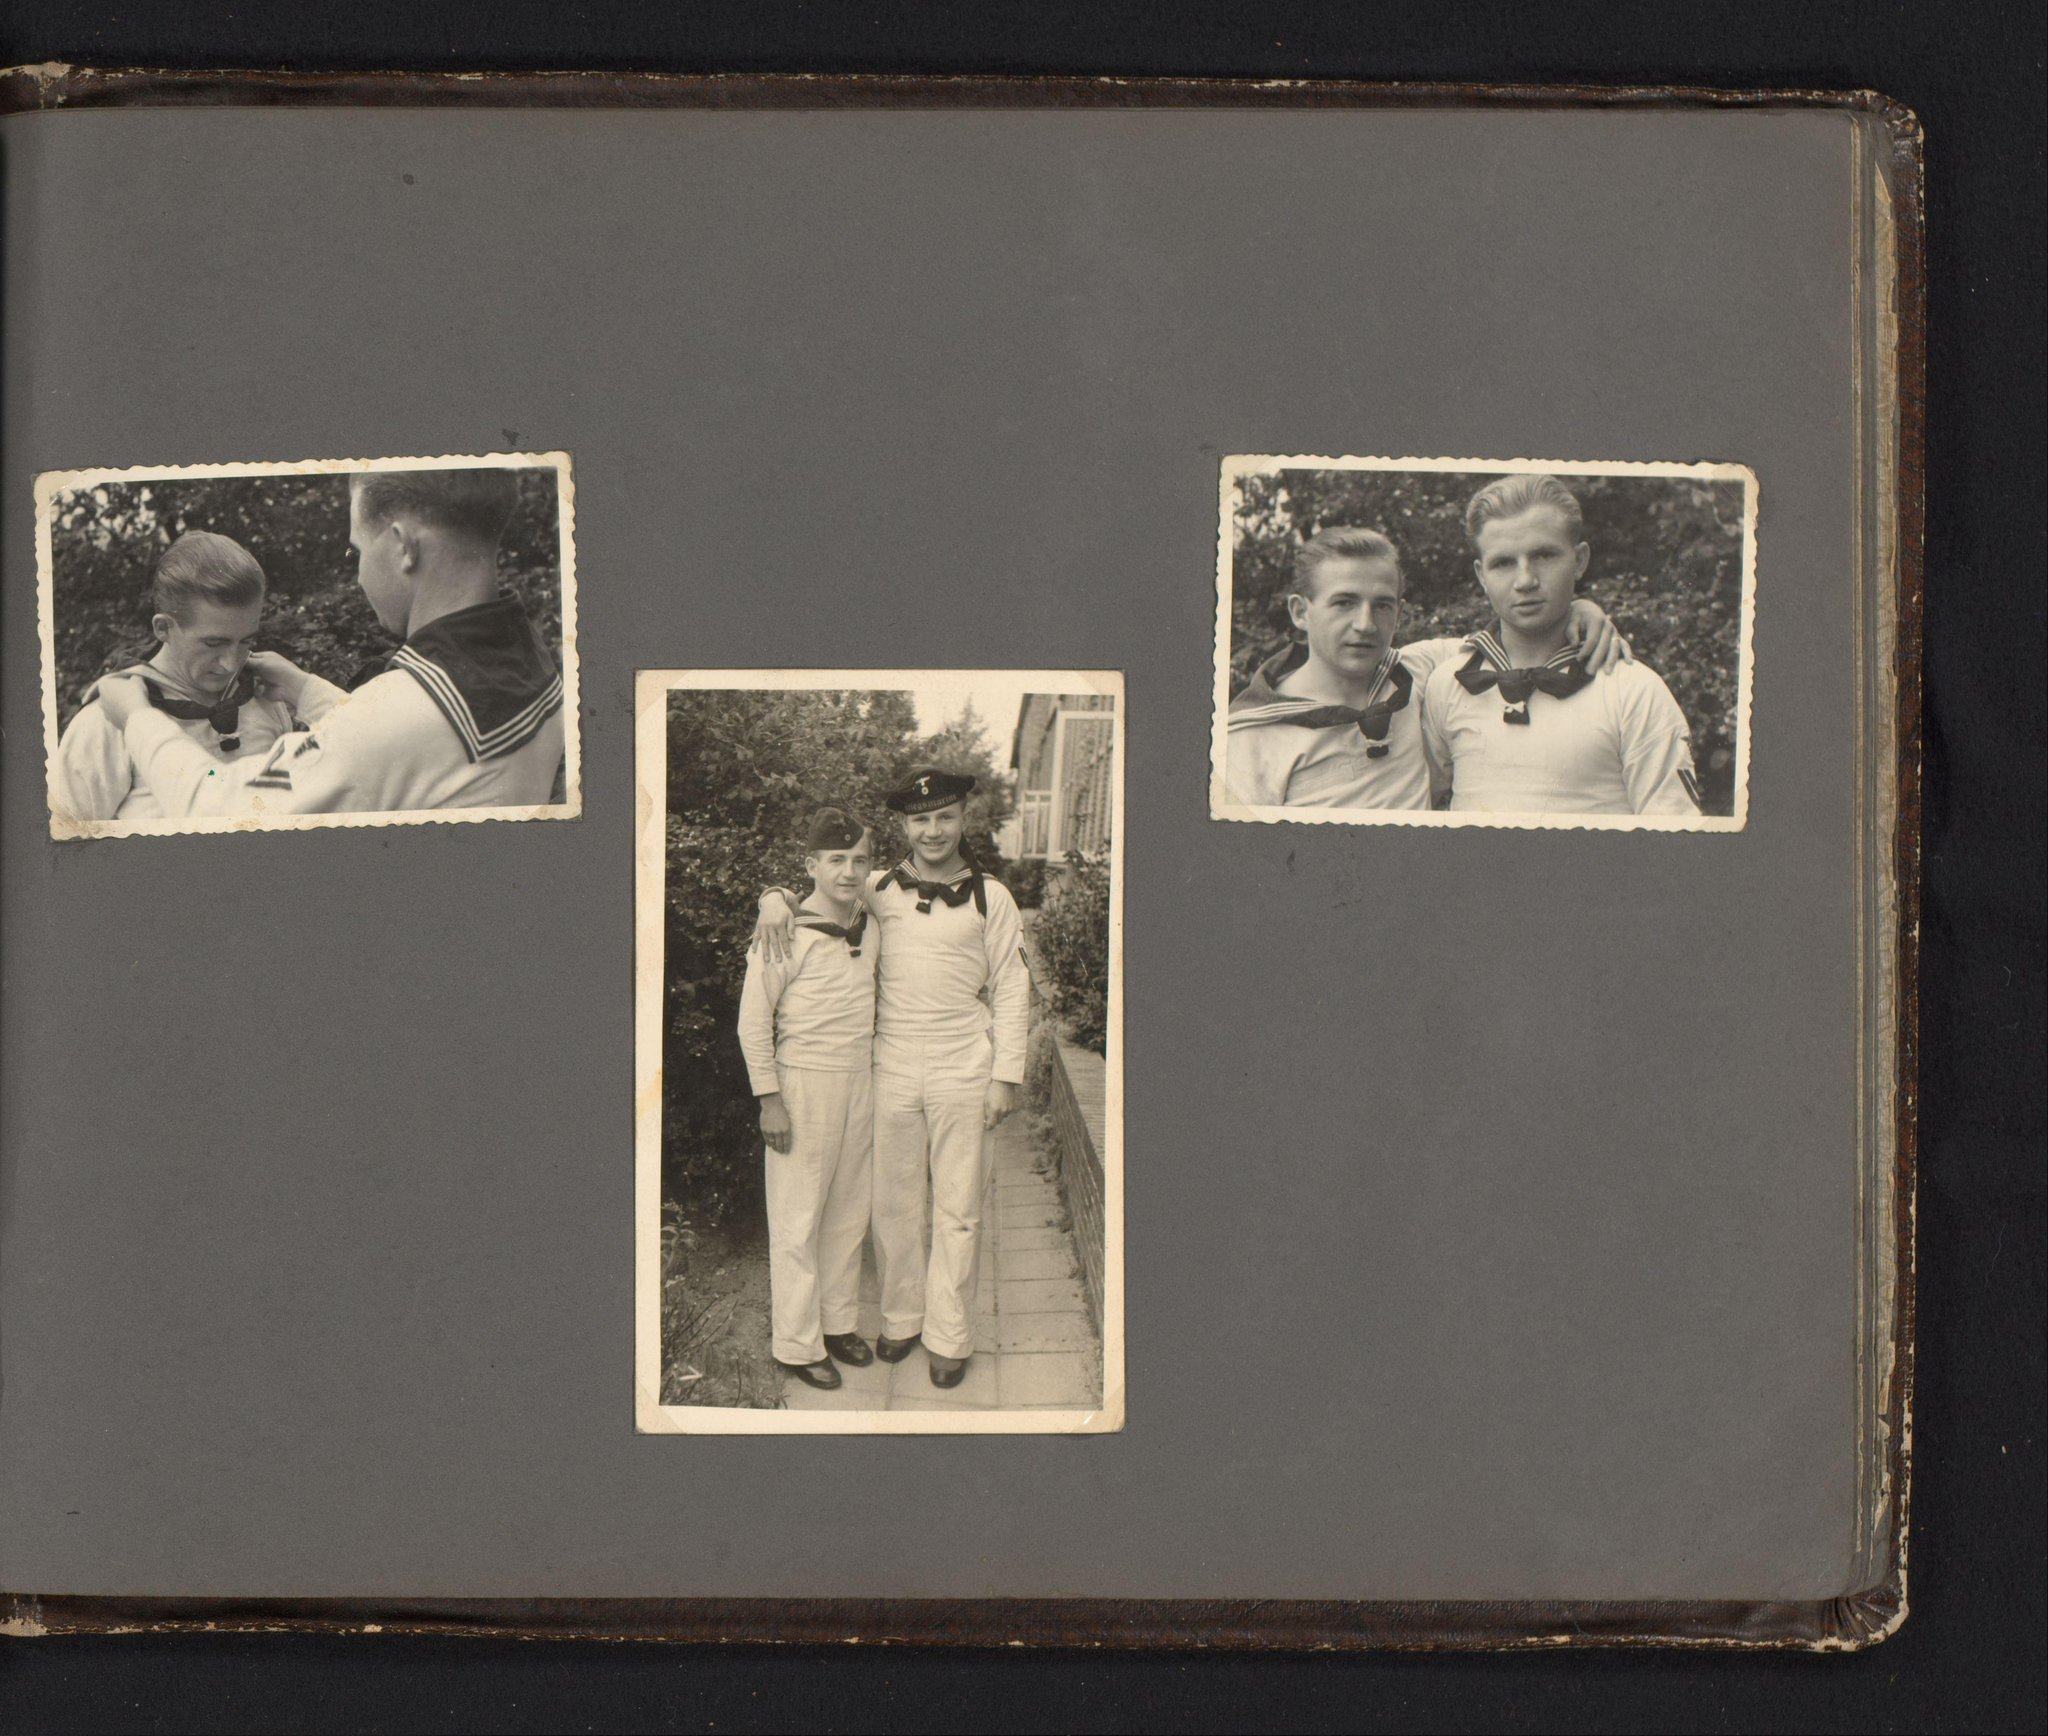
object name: photograph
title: Rheinhold Mohr met een vriend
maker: Anonymous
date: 1941-1945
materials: paper, photographic support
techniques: gelatin silver print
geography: germany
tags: reinhold mohr, the company, the unit, the troop ~ military service, sailor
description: Albumblad met drie foto's van de eigenaar van het album, Rheinhold Mohr (rechts op de foto) met Herbert Helms, waarschijnlijk zijn beste vriend. Deze vriend is op veel foto's te zien. Onderdeel van het fotoalbum Kriegsmarine.